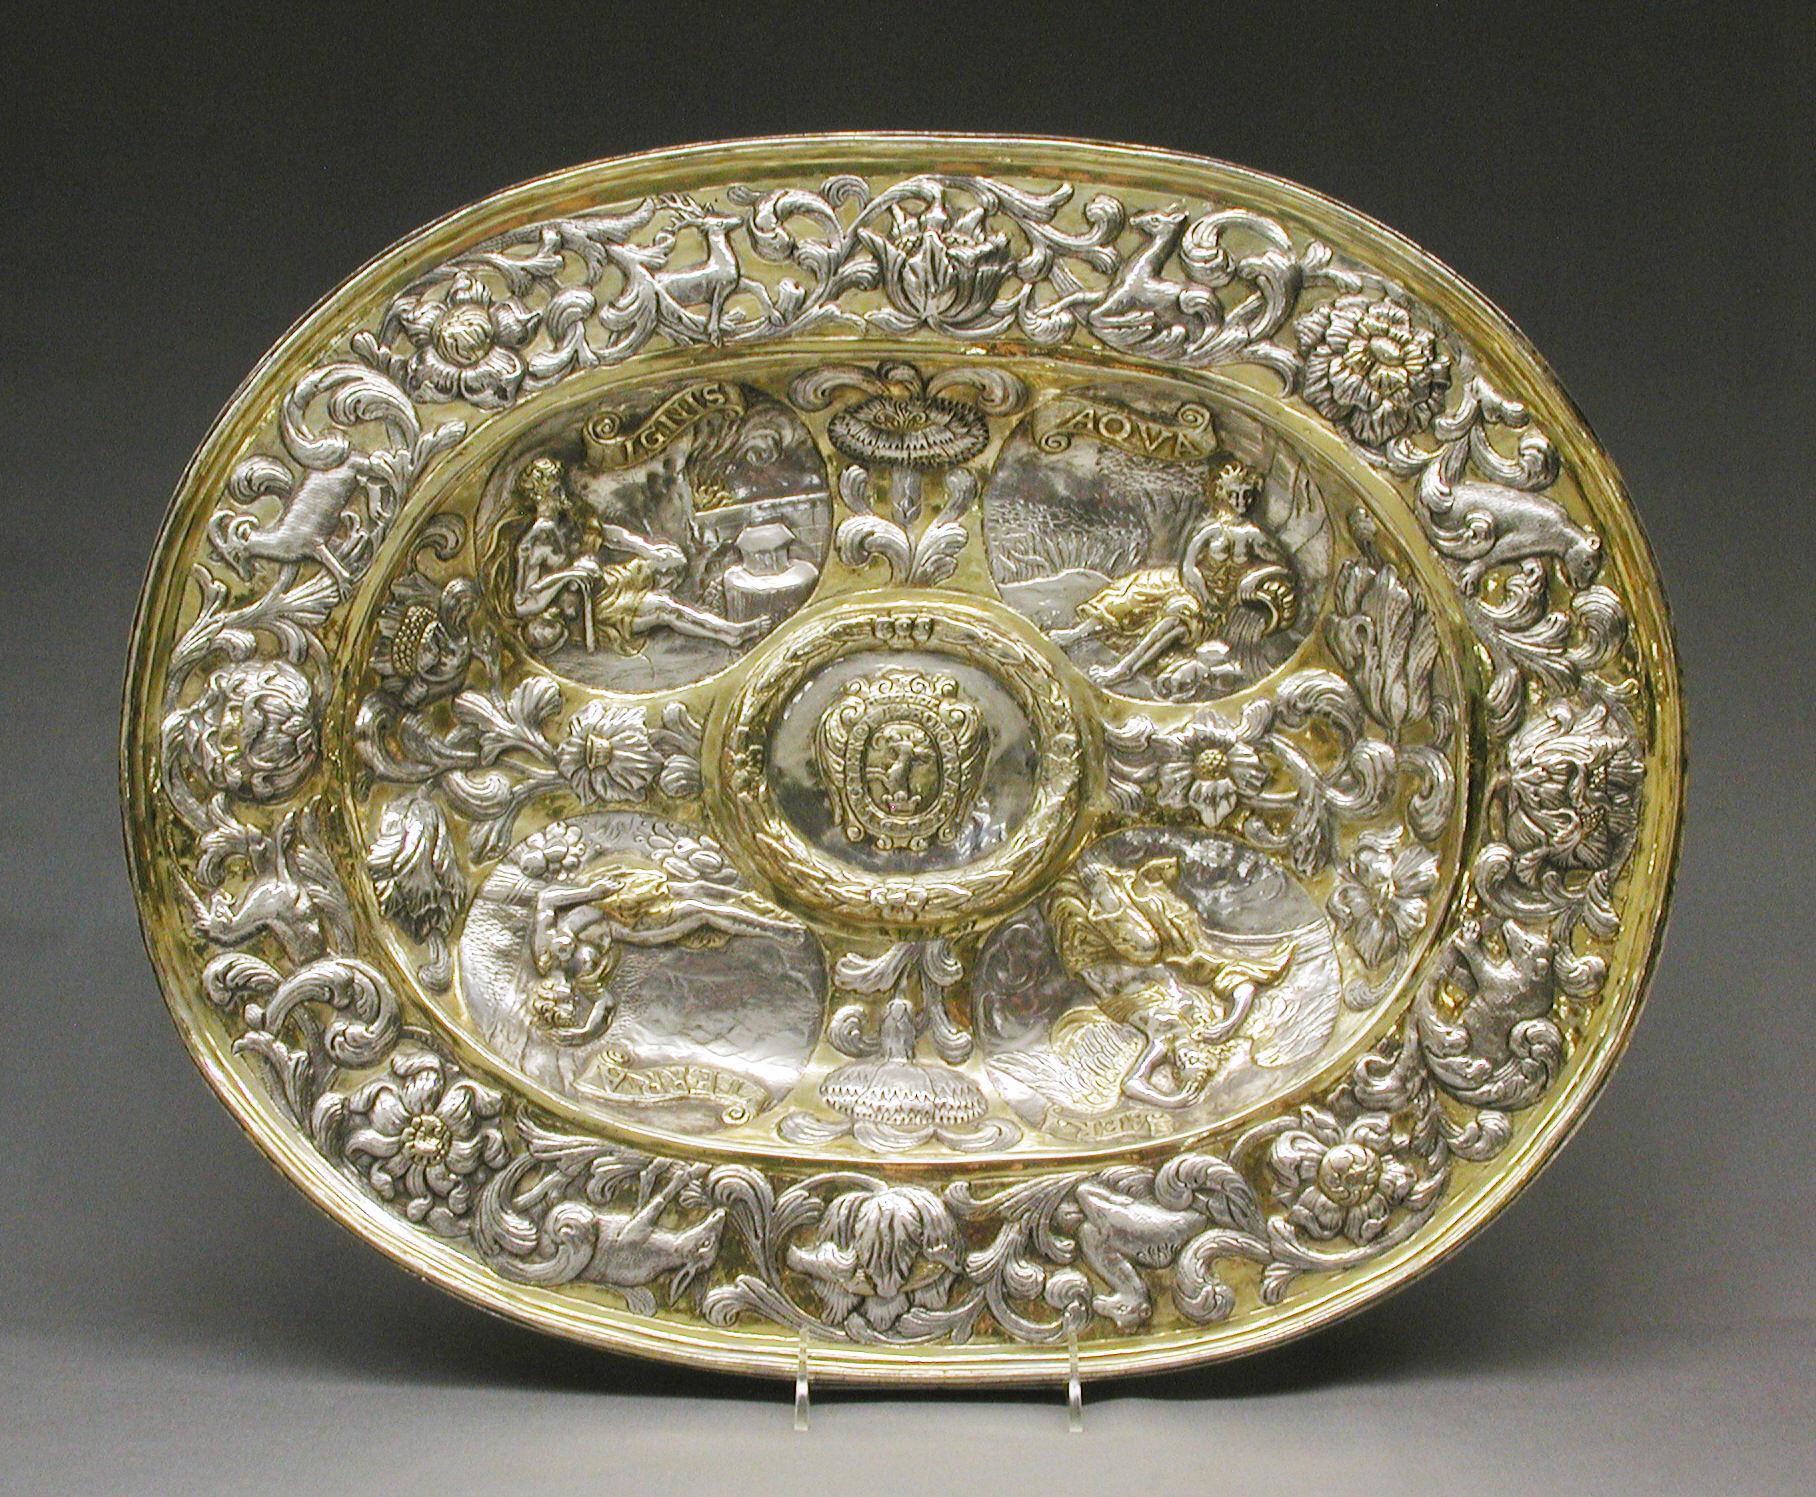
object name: charger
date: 1694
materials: silver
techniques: gilding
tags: animals,bears,unicorns,camels,deer,allegory